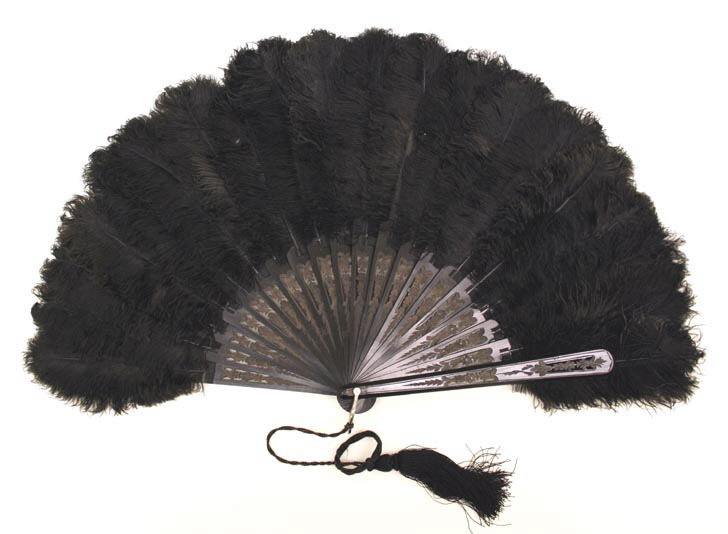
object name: fan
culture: american or european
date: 1867-1900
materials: feather, wood